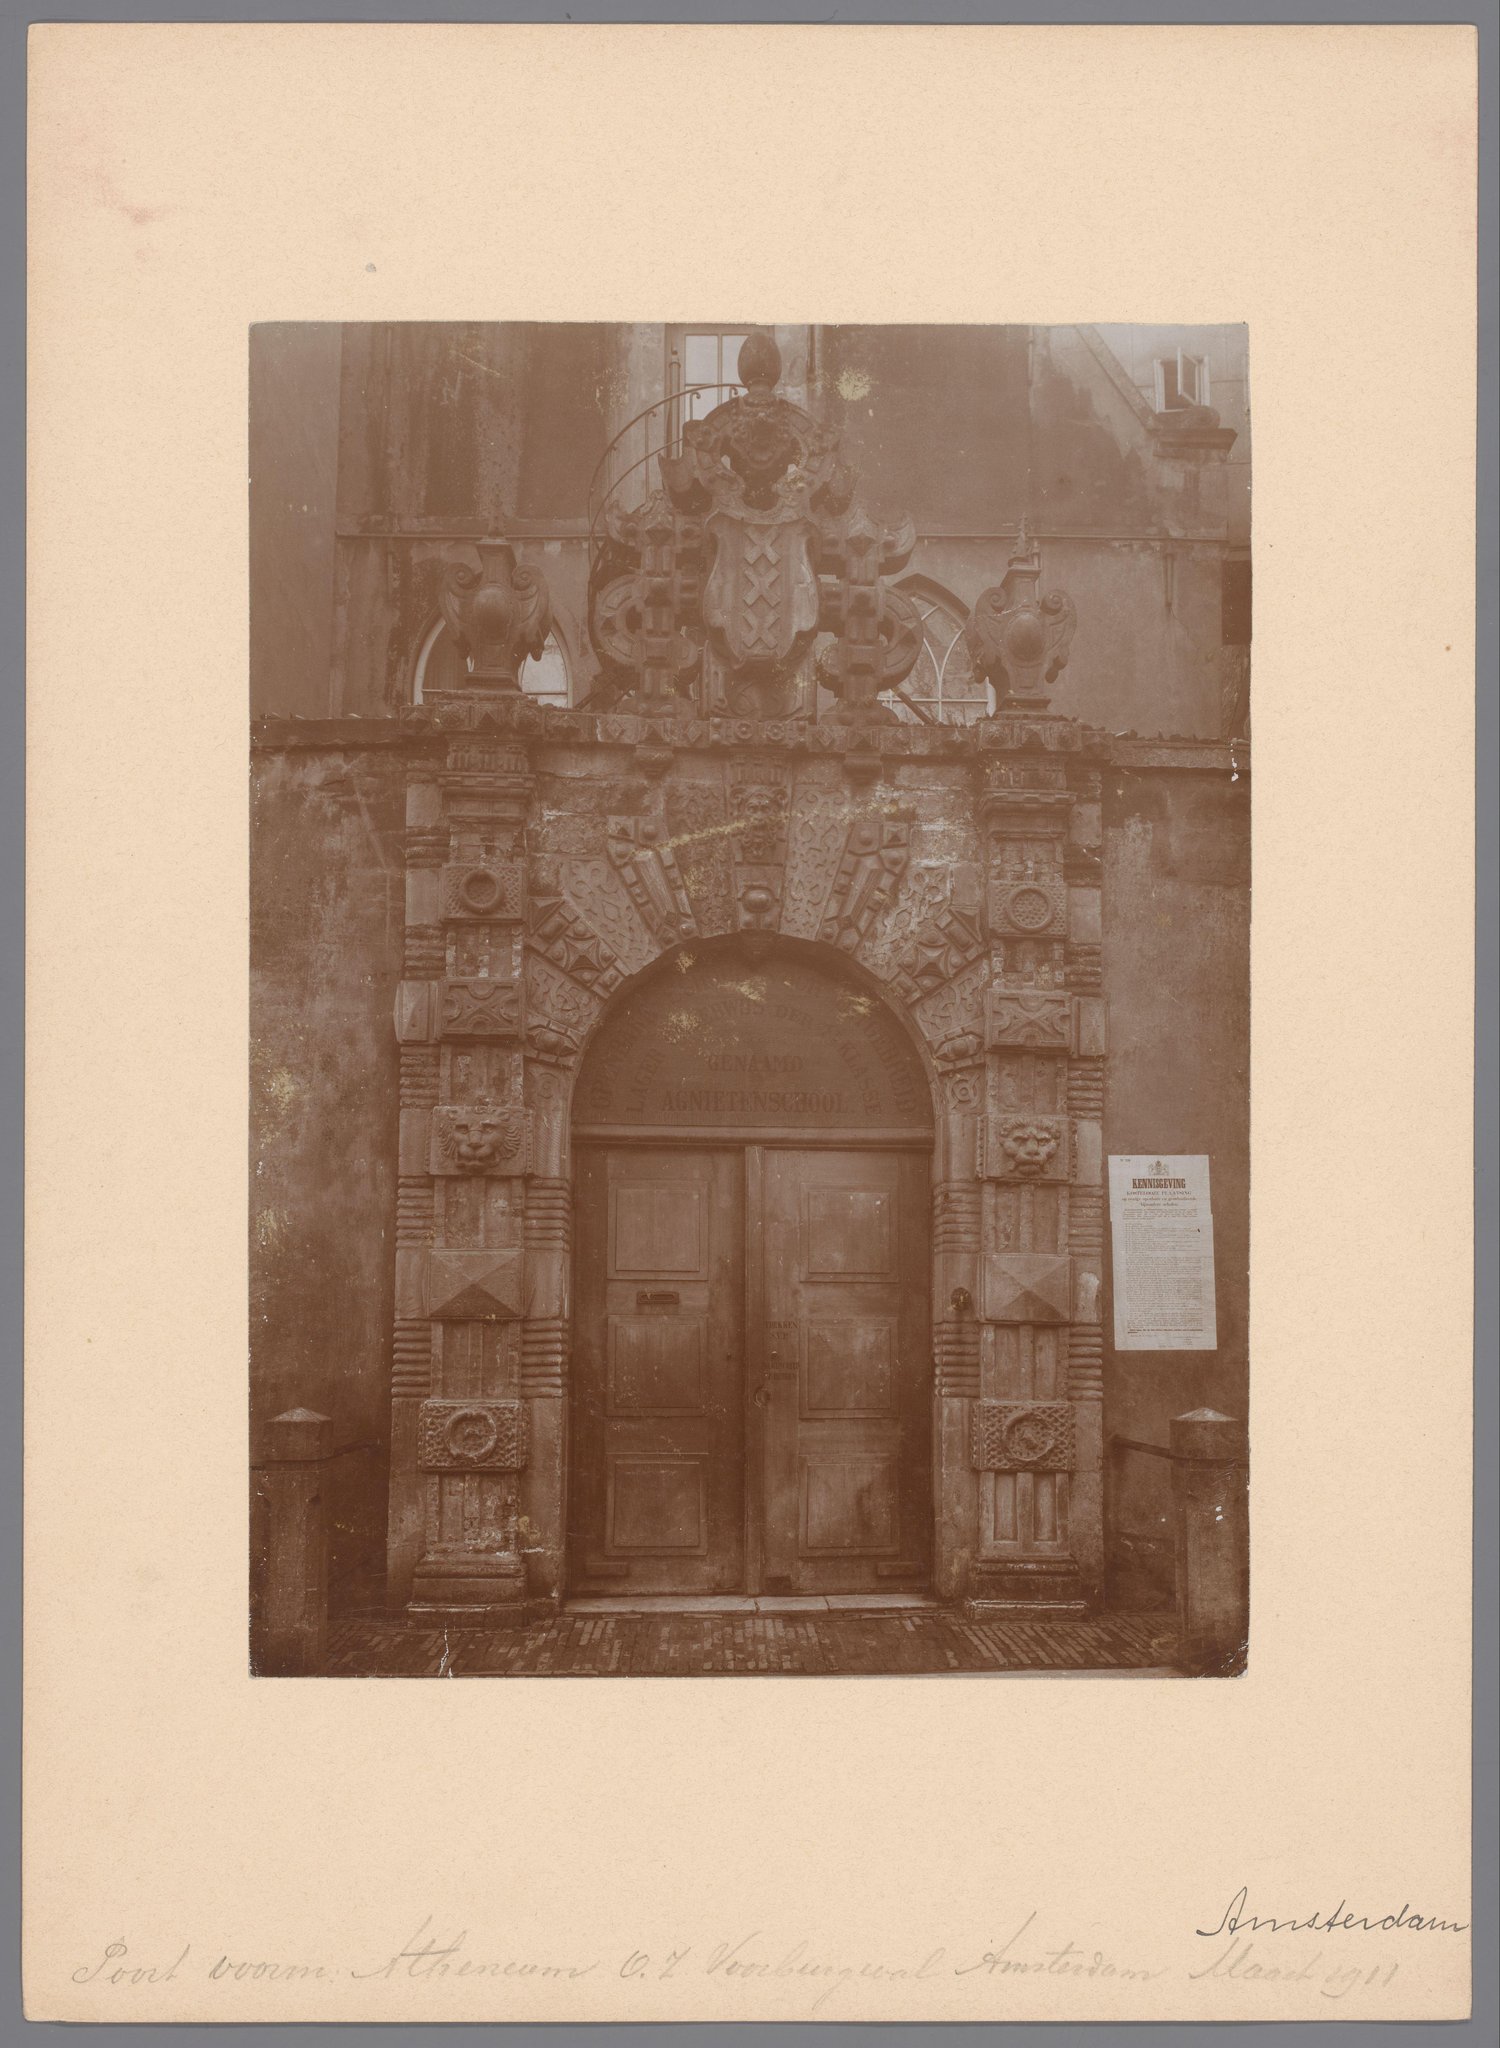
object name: photograph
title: Poort van de Agnietenschool aan de Oudezijds Voorburgwal 231 te Amsterdam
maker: anoniem (monumentenzorg)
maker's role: fotograaf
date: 1911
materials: cardboard, photographic support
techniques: collodion silver print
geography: oudezijds voorburgwal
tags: gate, entrance, elementary school; class, form (+ building ~ education, tuition)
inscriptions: annotation: ‘Poort voorm. Atheneum O.Z. Voorburgwal Amsterdam Maart 1911/ Amsterdam’, annotation: ‘W.C. van Manen 1774-1832’